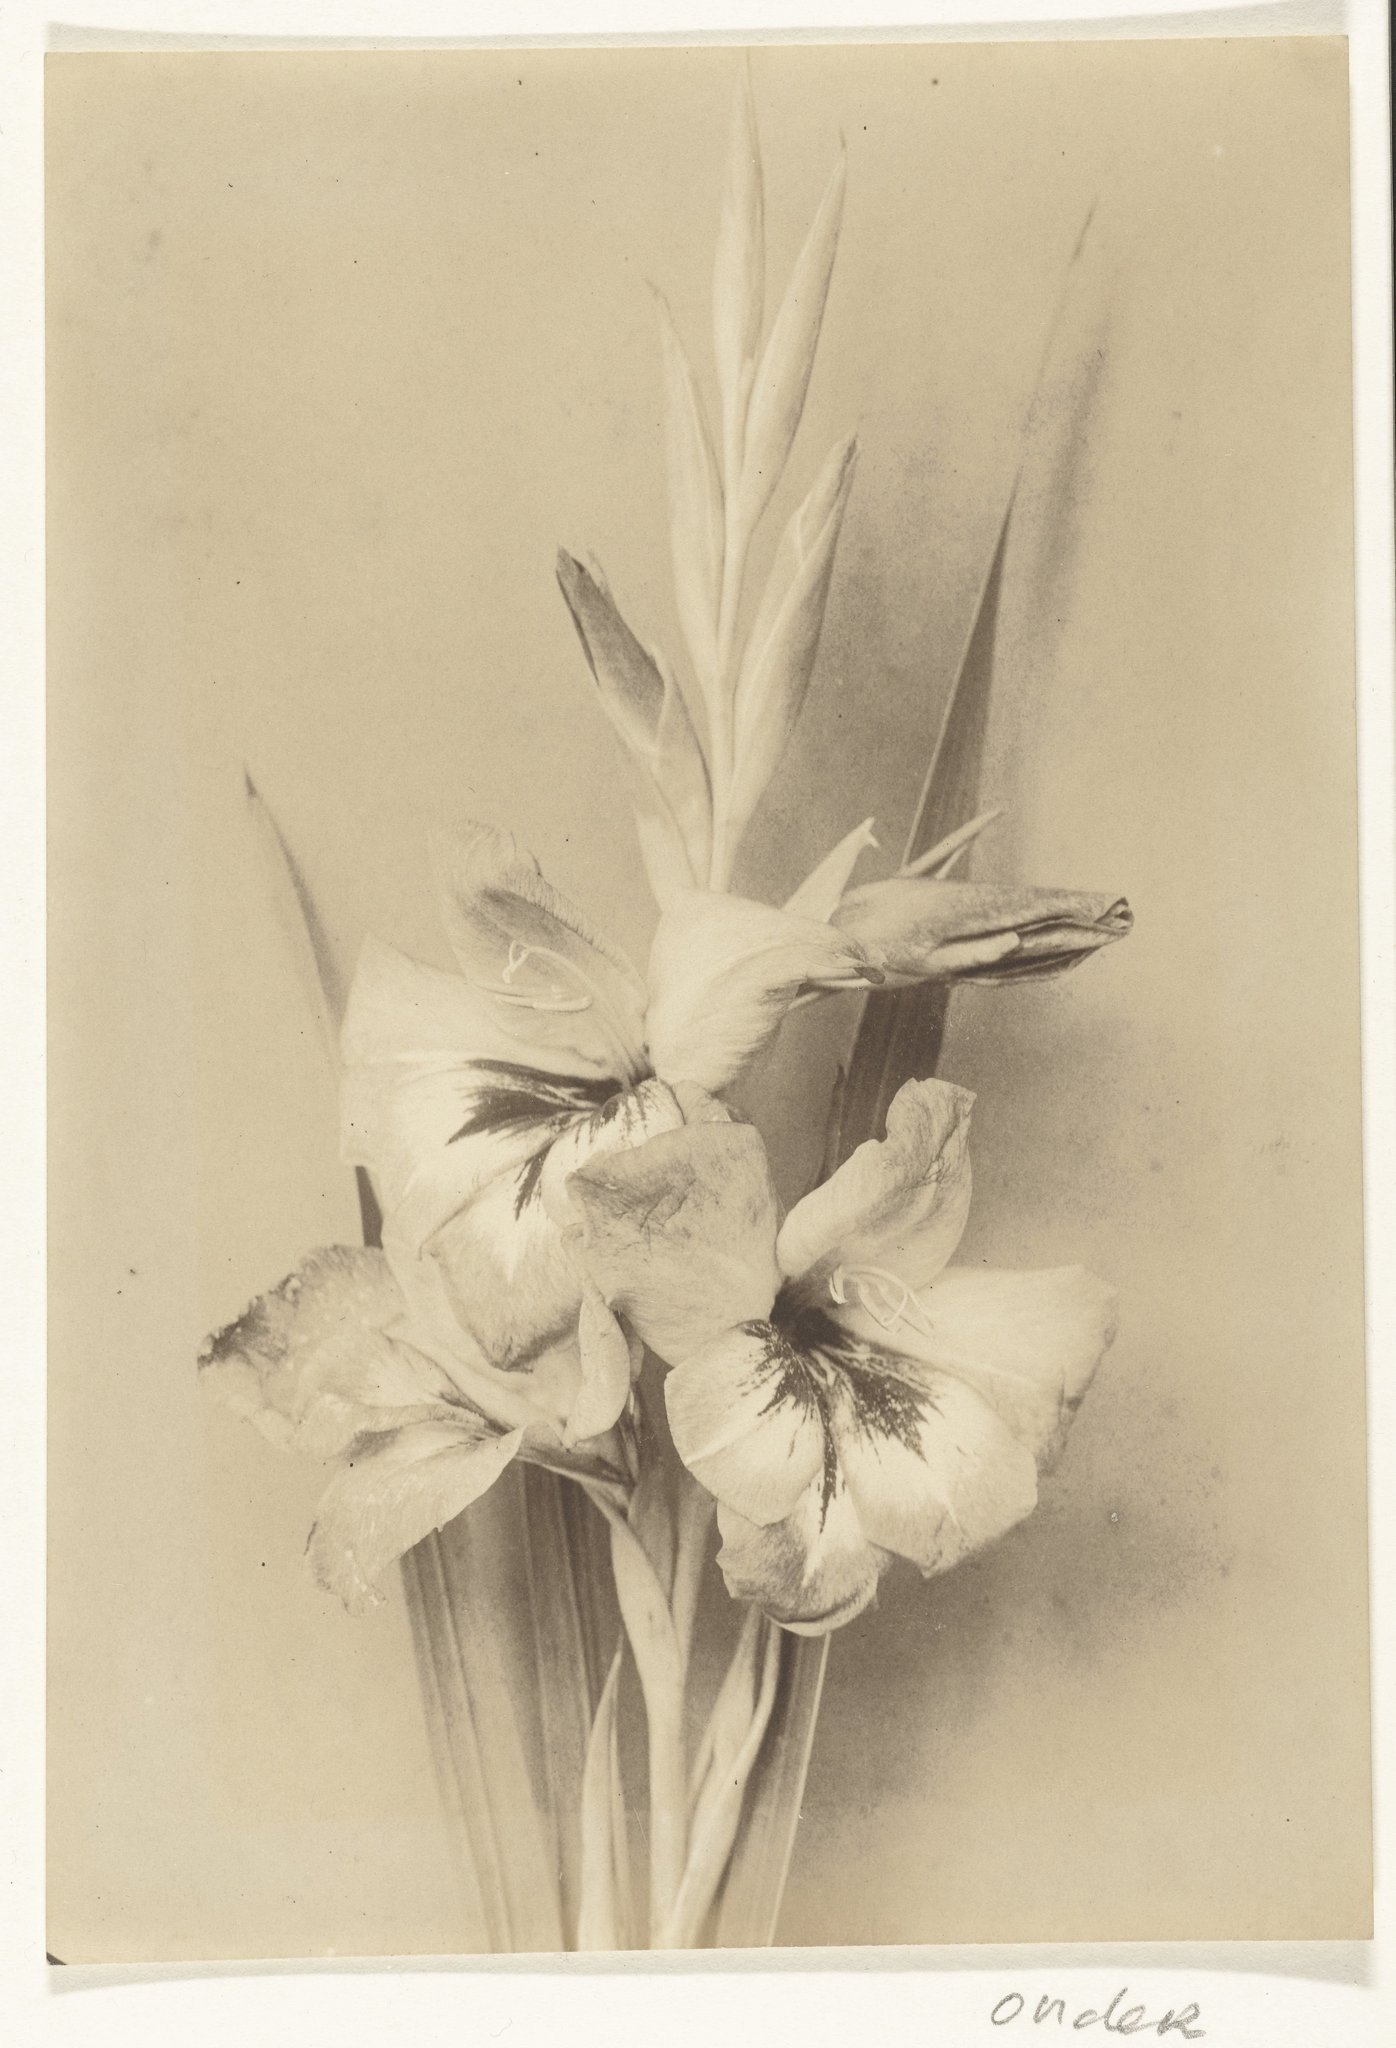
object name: photograph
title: Tak van een gladiool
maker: richard tepe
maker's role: fotograaf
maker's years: 1864-1952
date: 1900-1930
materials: photographic support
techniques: gelatin silver print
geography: netherlands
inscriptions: annotation: ‘Gladiolas / Rosa Lindt’, signature: ‘R Tepe / foto’